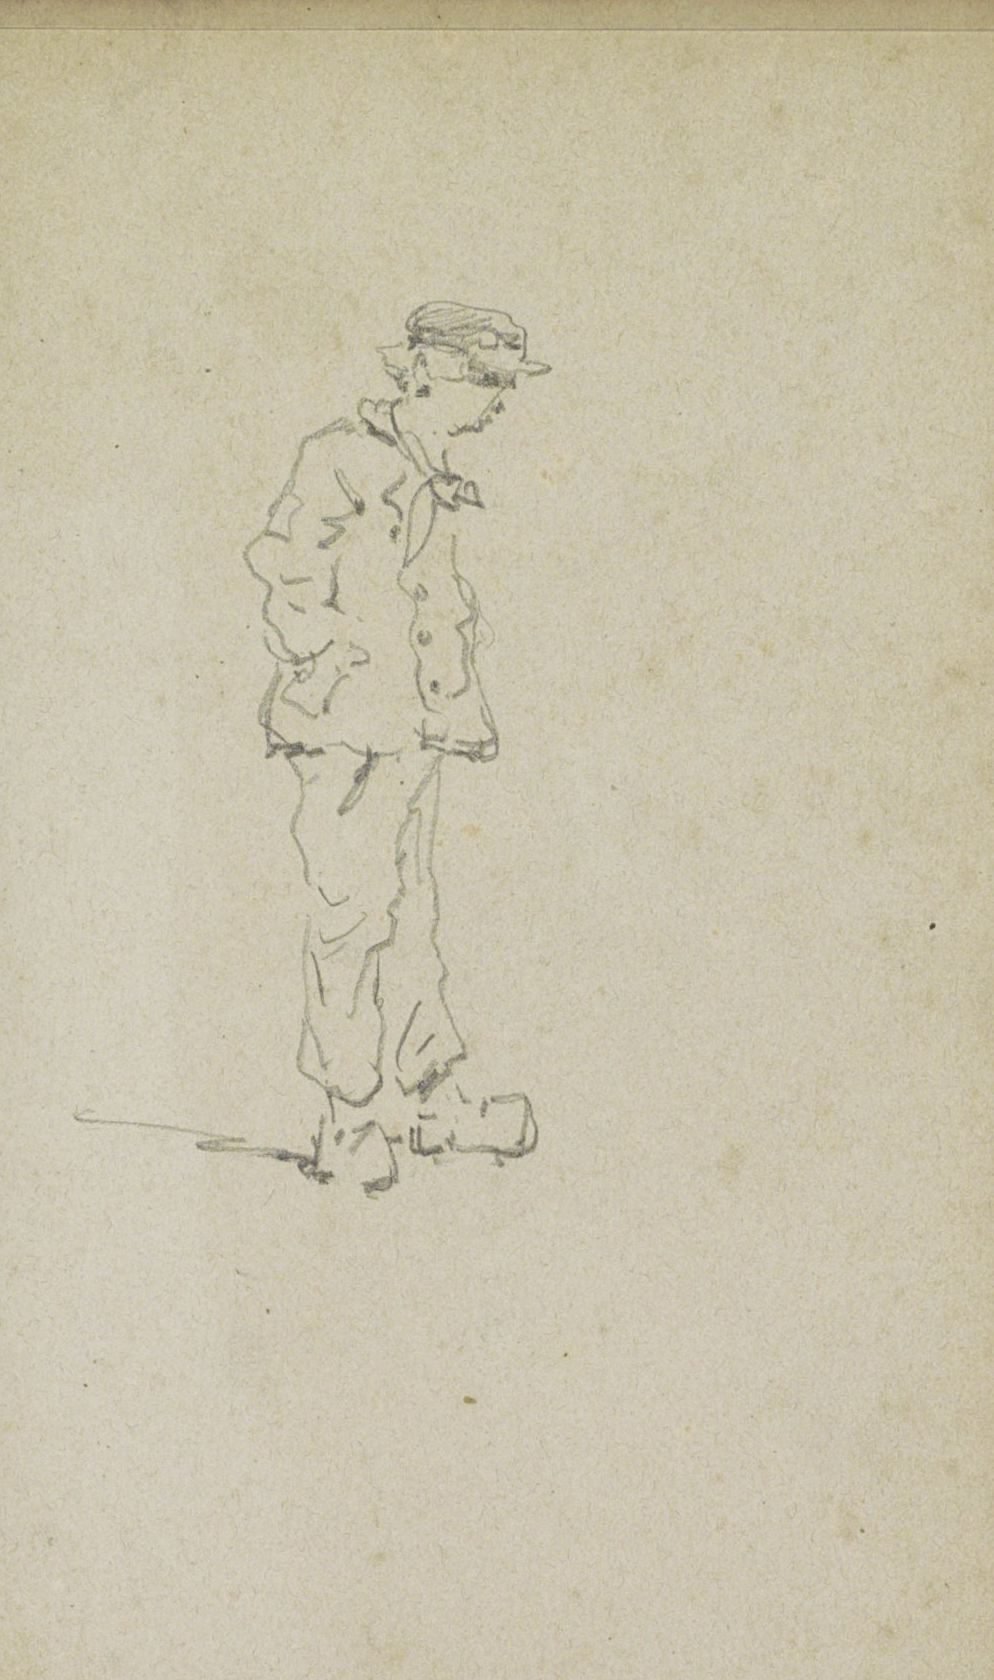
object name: sketchbook leaf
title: Boer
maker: adrianus eversen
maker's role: draughtsman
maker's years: 1818-1897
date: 1828-1897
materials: paper, pencil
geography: netherlands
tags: wooden shoes, clogs, farmers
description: Boer op klompen met de handen in zijn zakken. Blad 54 recto uit een schetsboek met 69 bladen vervaardigd in de omgeving van Delft, Rotterdam, Oudewater en Harlingen.